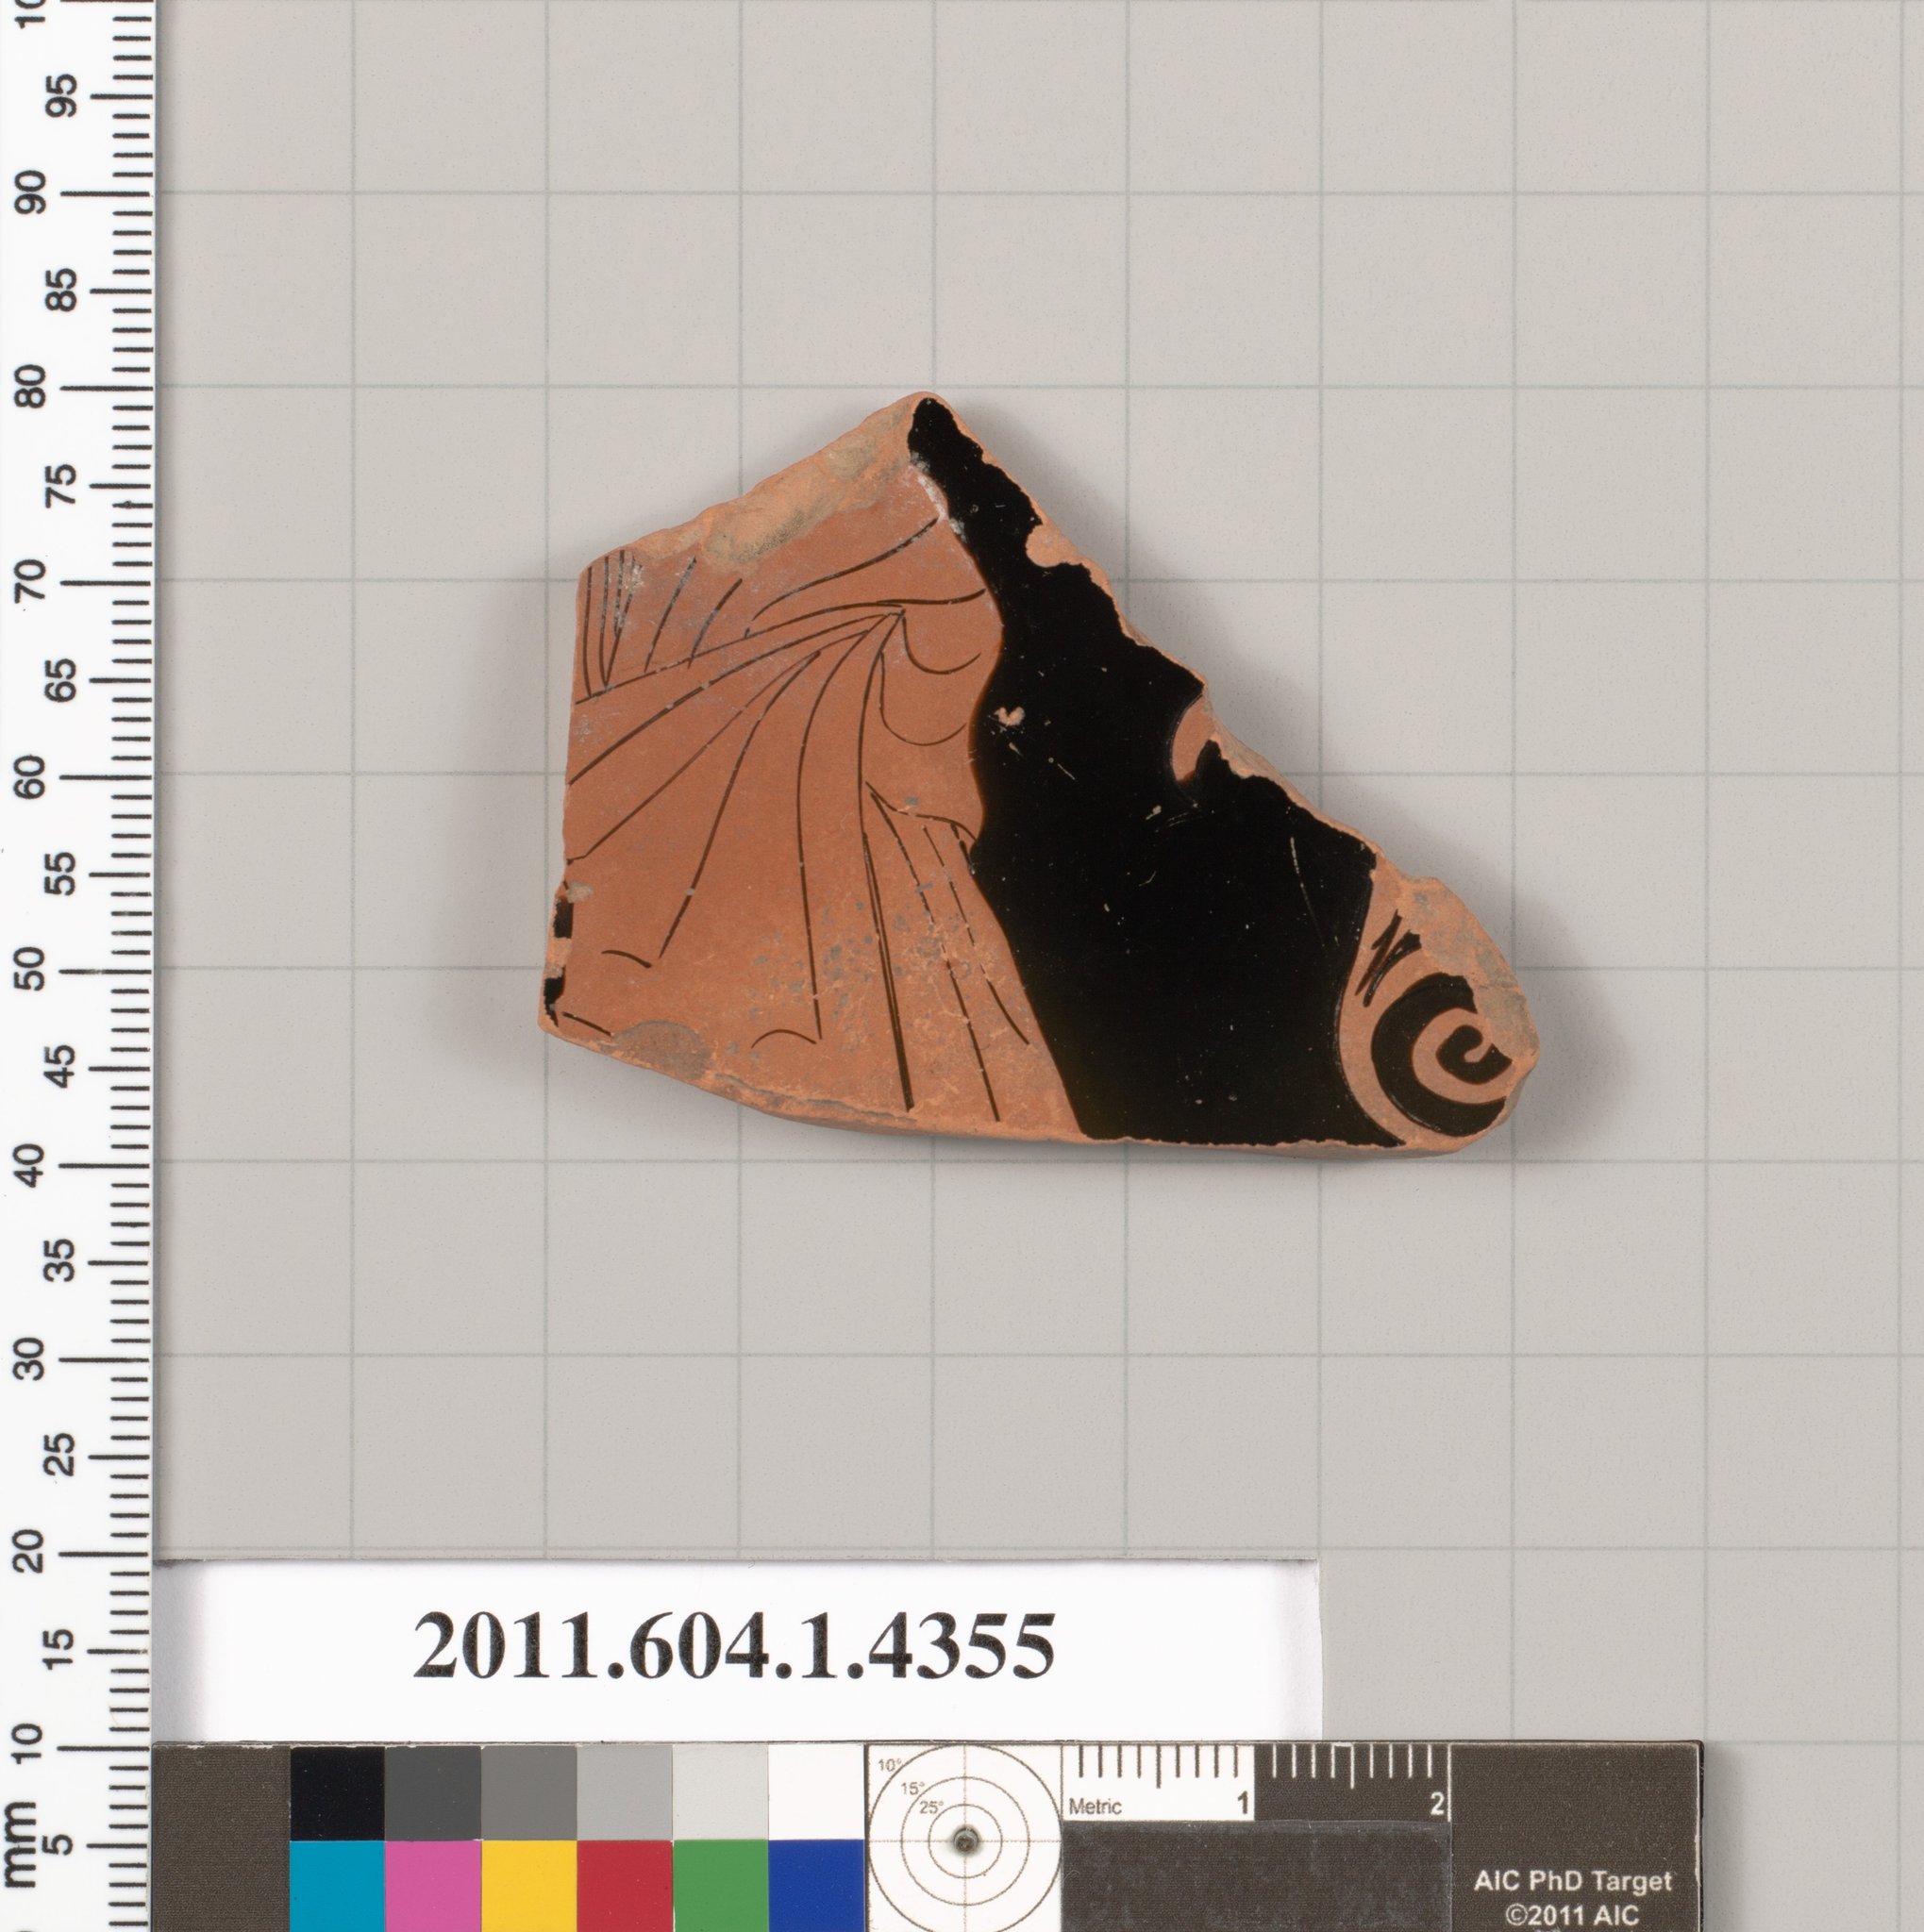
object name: kylix fragment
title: Terracotta fragment of a kylix (drinking cup)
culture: greek, attic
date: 475-451 BCE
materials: terracotta